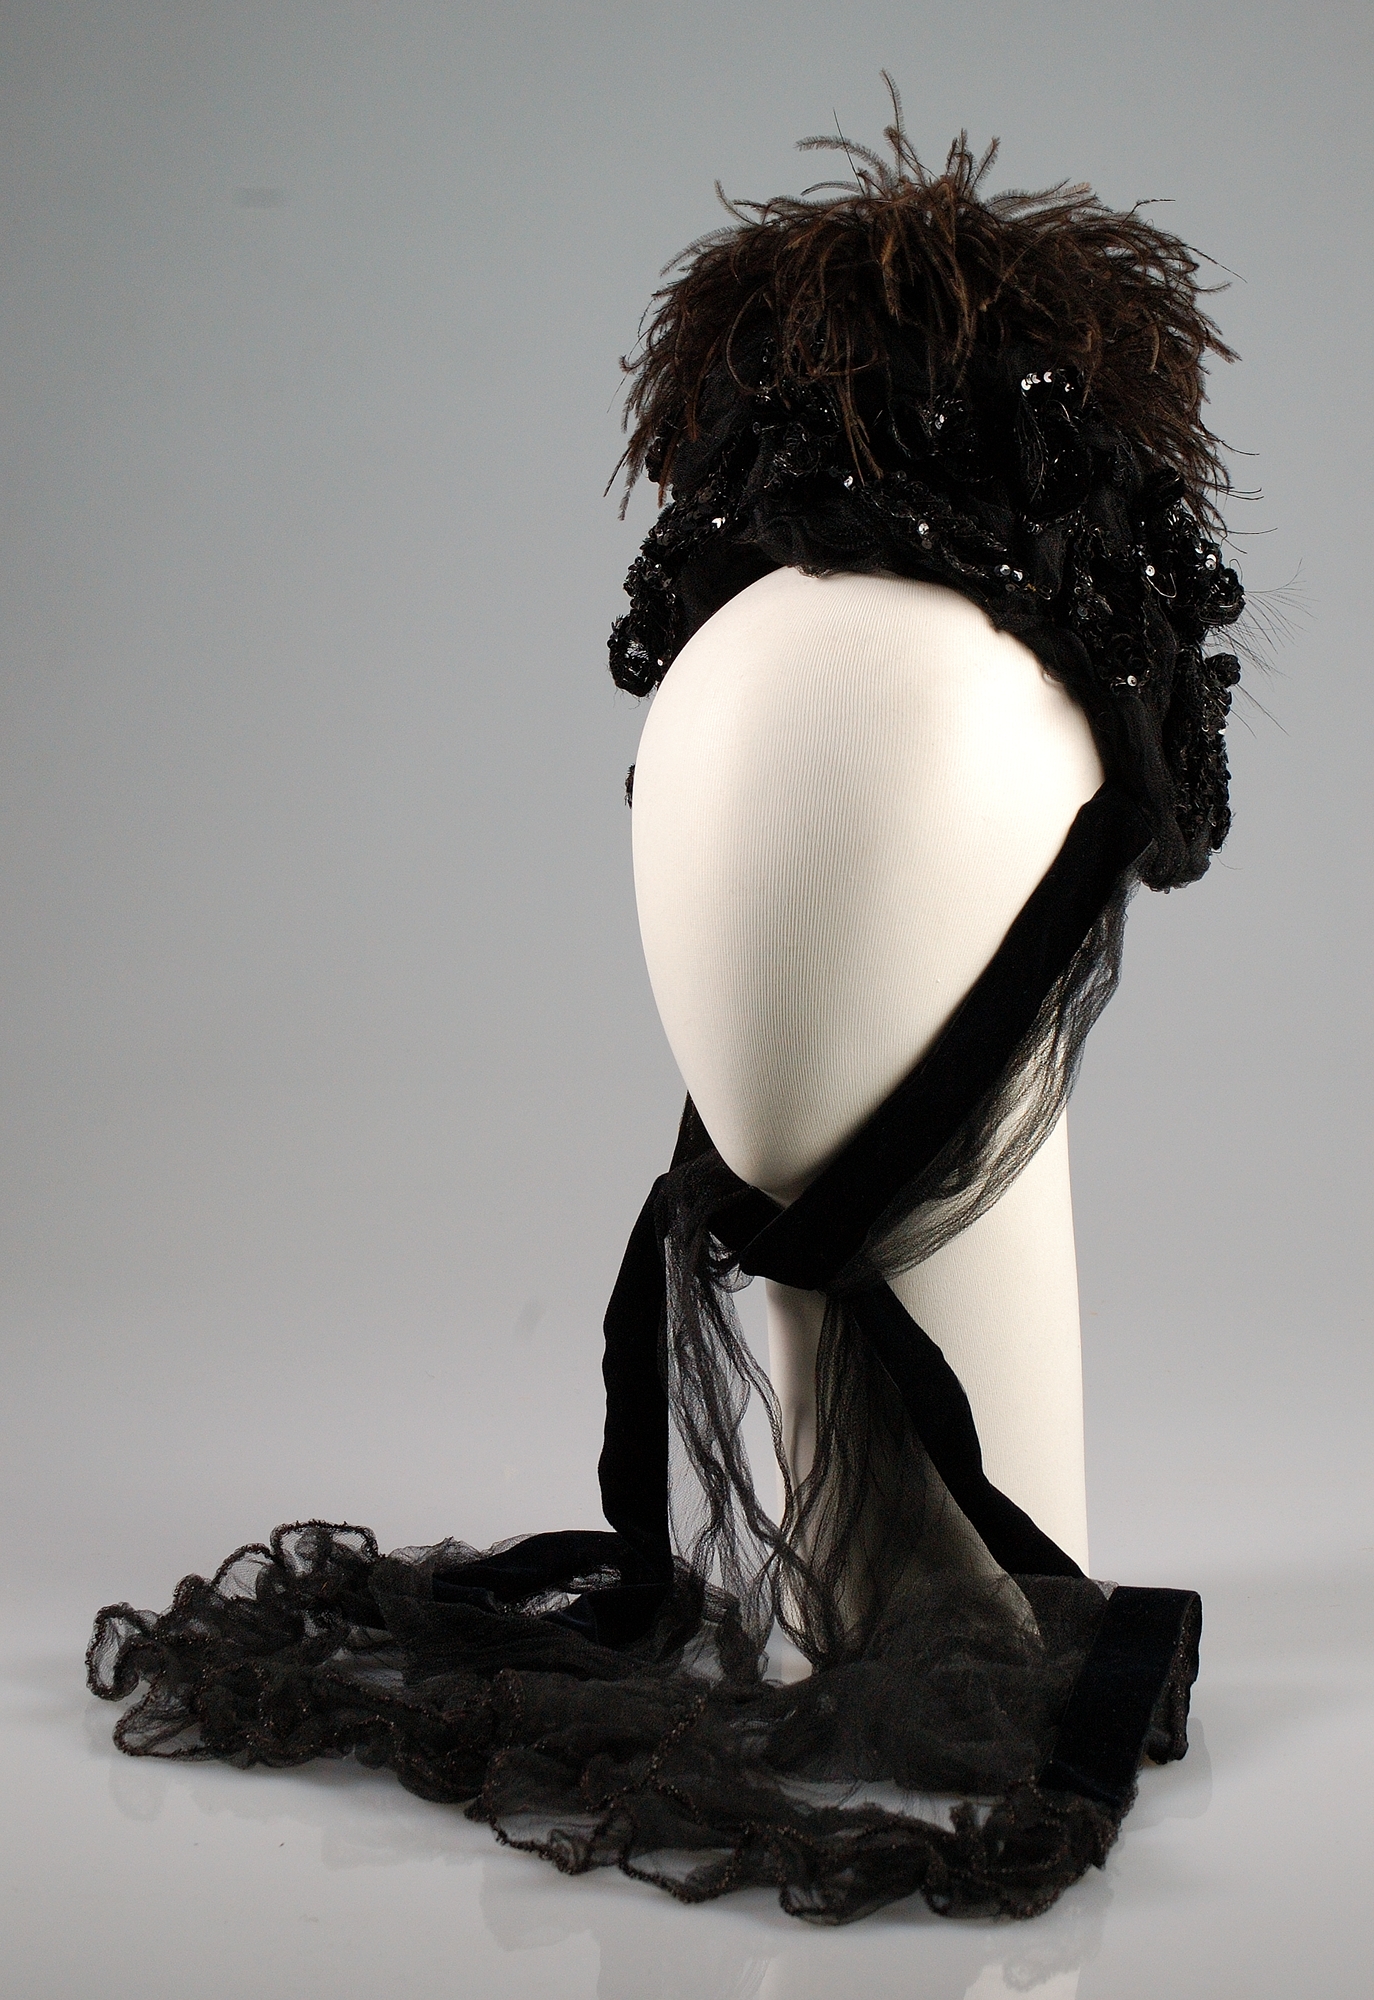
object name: evening bonnet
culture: french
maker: camille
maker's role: maker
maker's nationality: french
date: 1890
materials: feather, silk, fiber